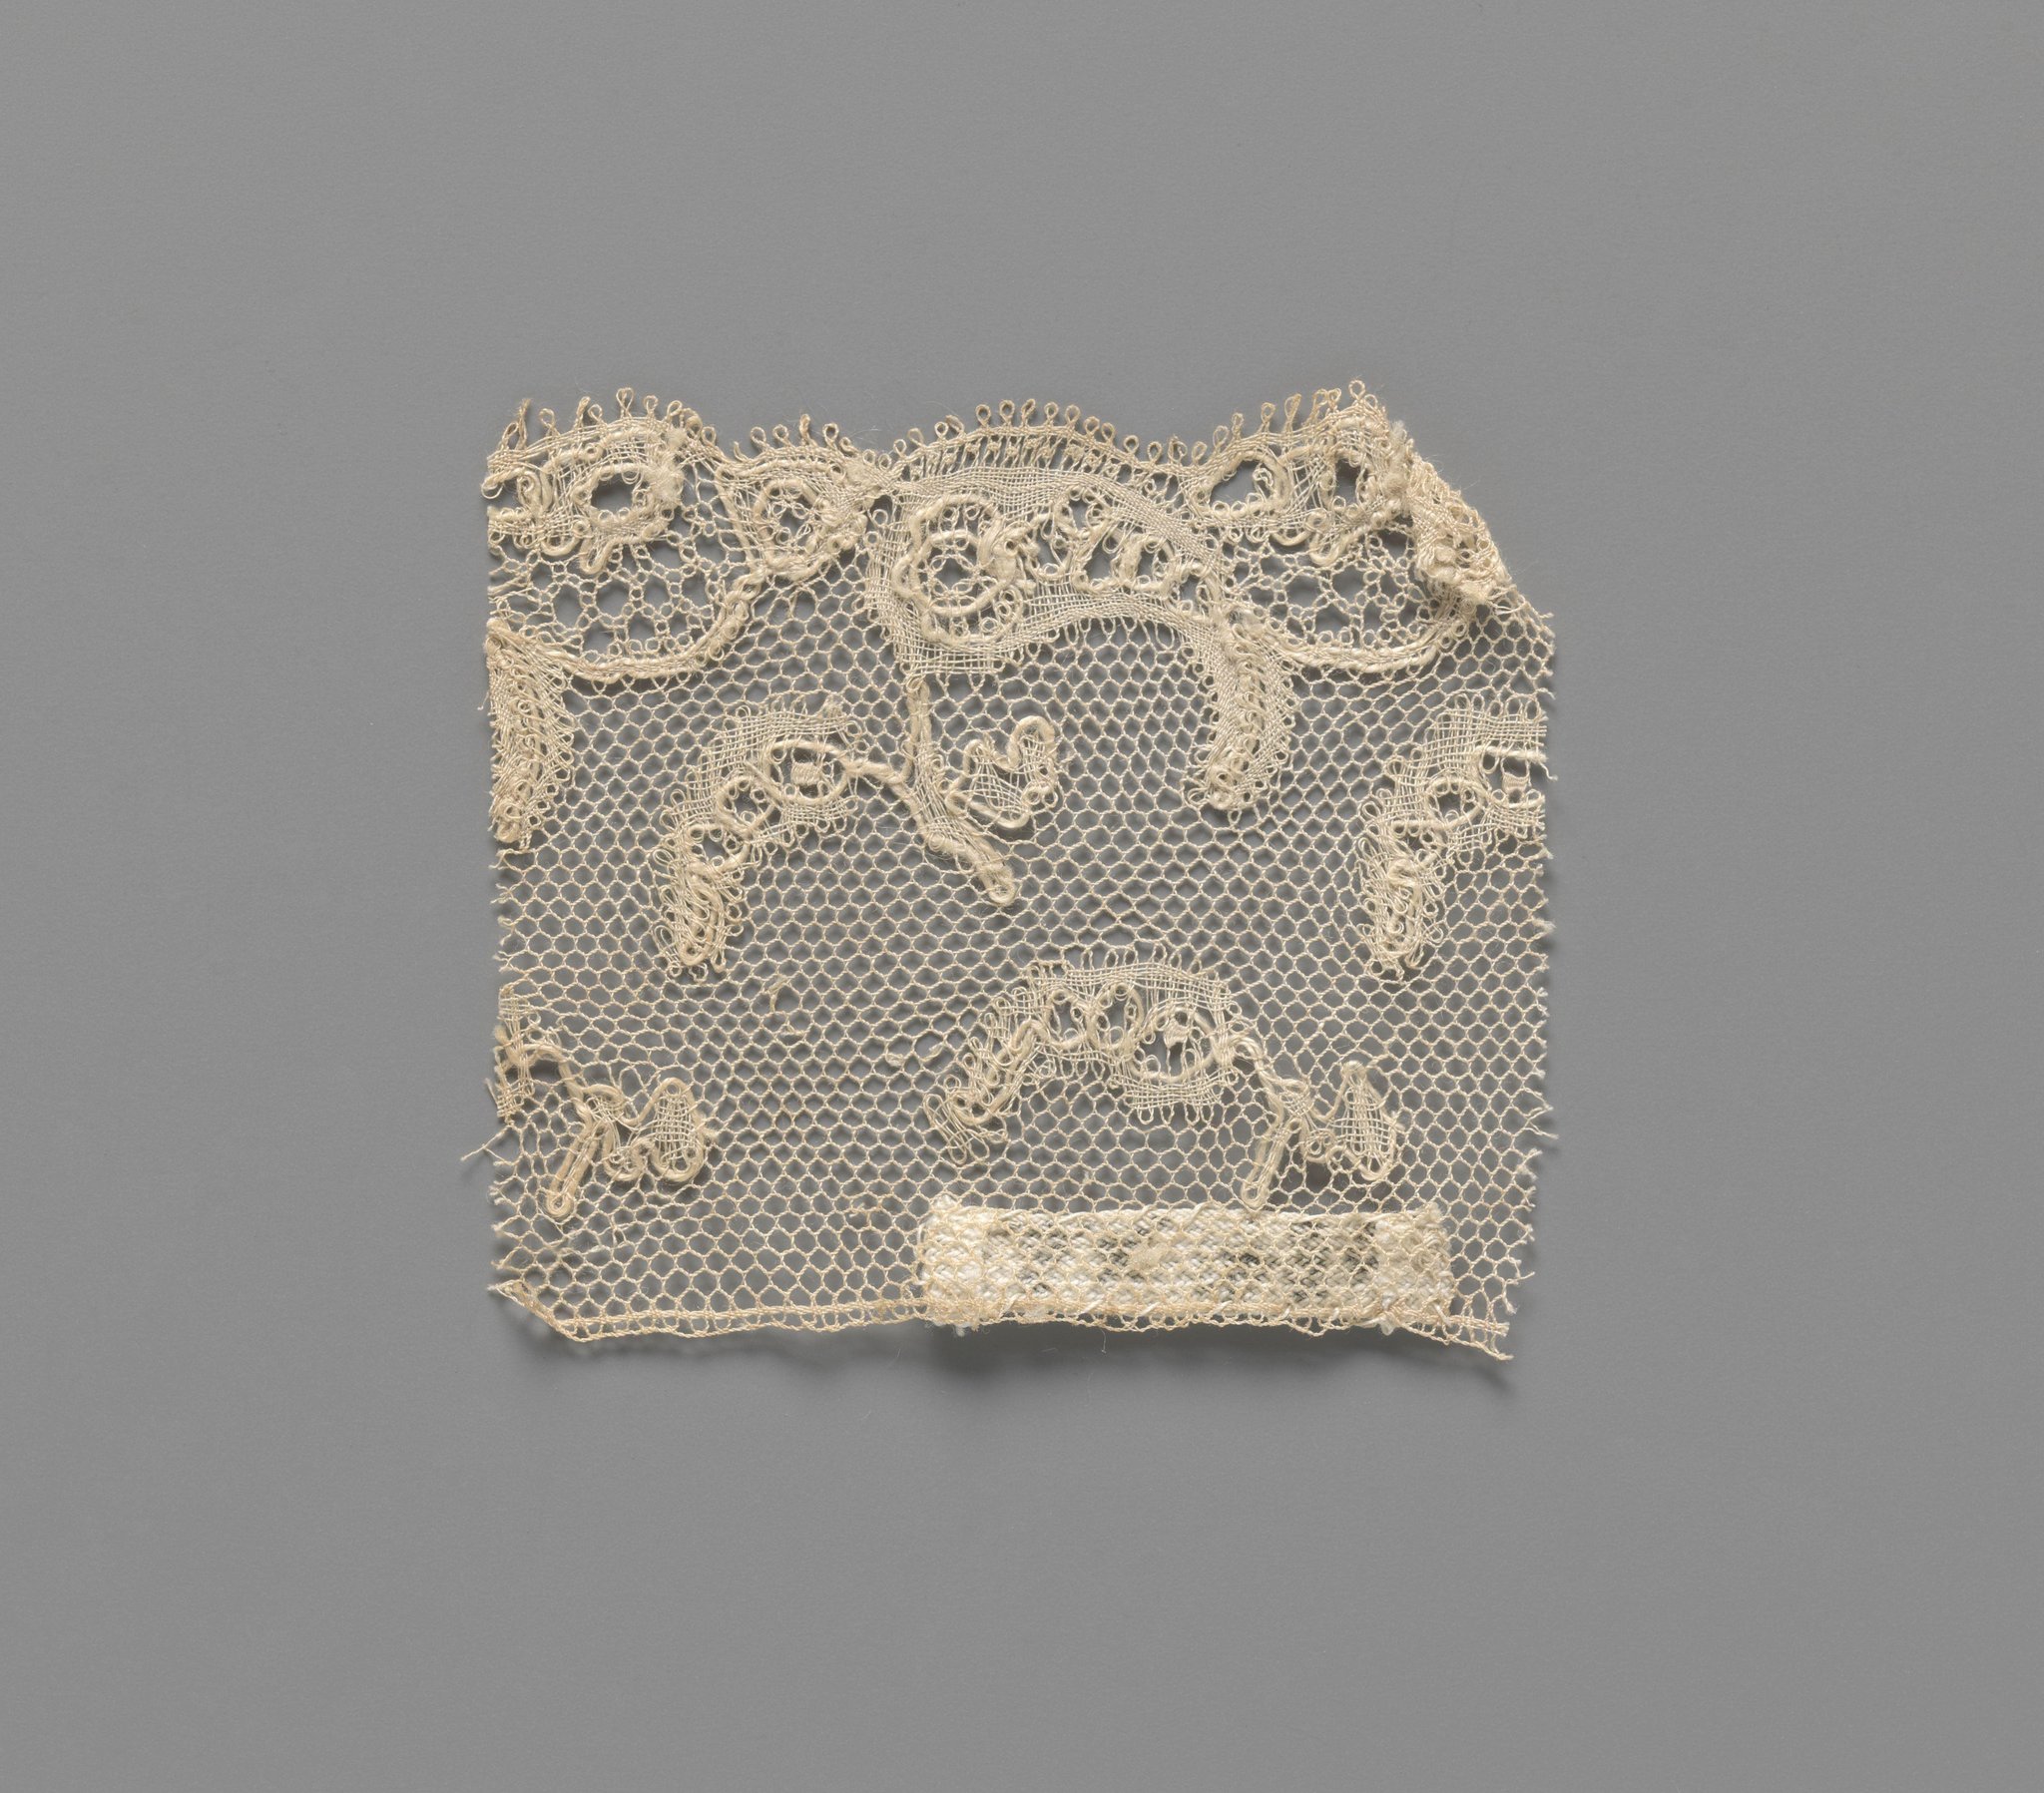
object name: sample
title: Staal kloskant met tulegrond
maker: Anonymous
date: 1875-1899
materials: cotton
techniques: lace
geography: turnhout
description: Staal of kort stuk van een strook naturelkleurige kloskant: Rijsselse kant. Afkomstig van een opgeheven kantschool te Turnhout.